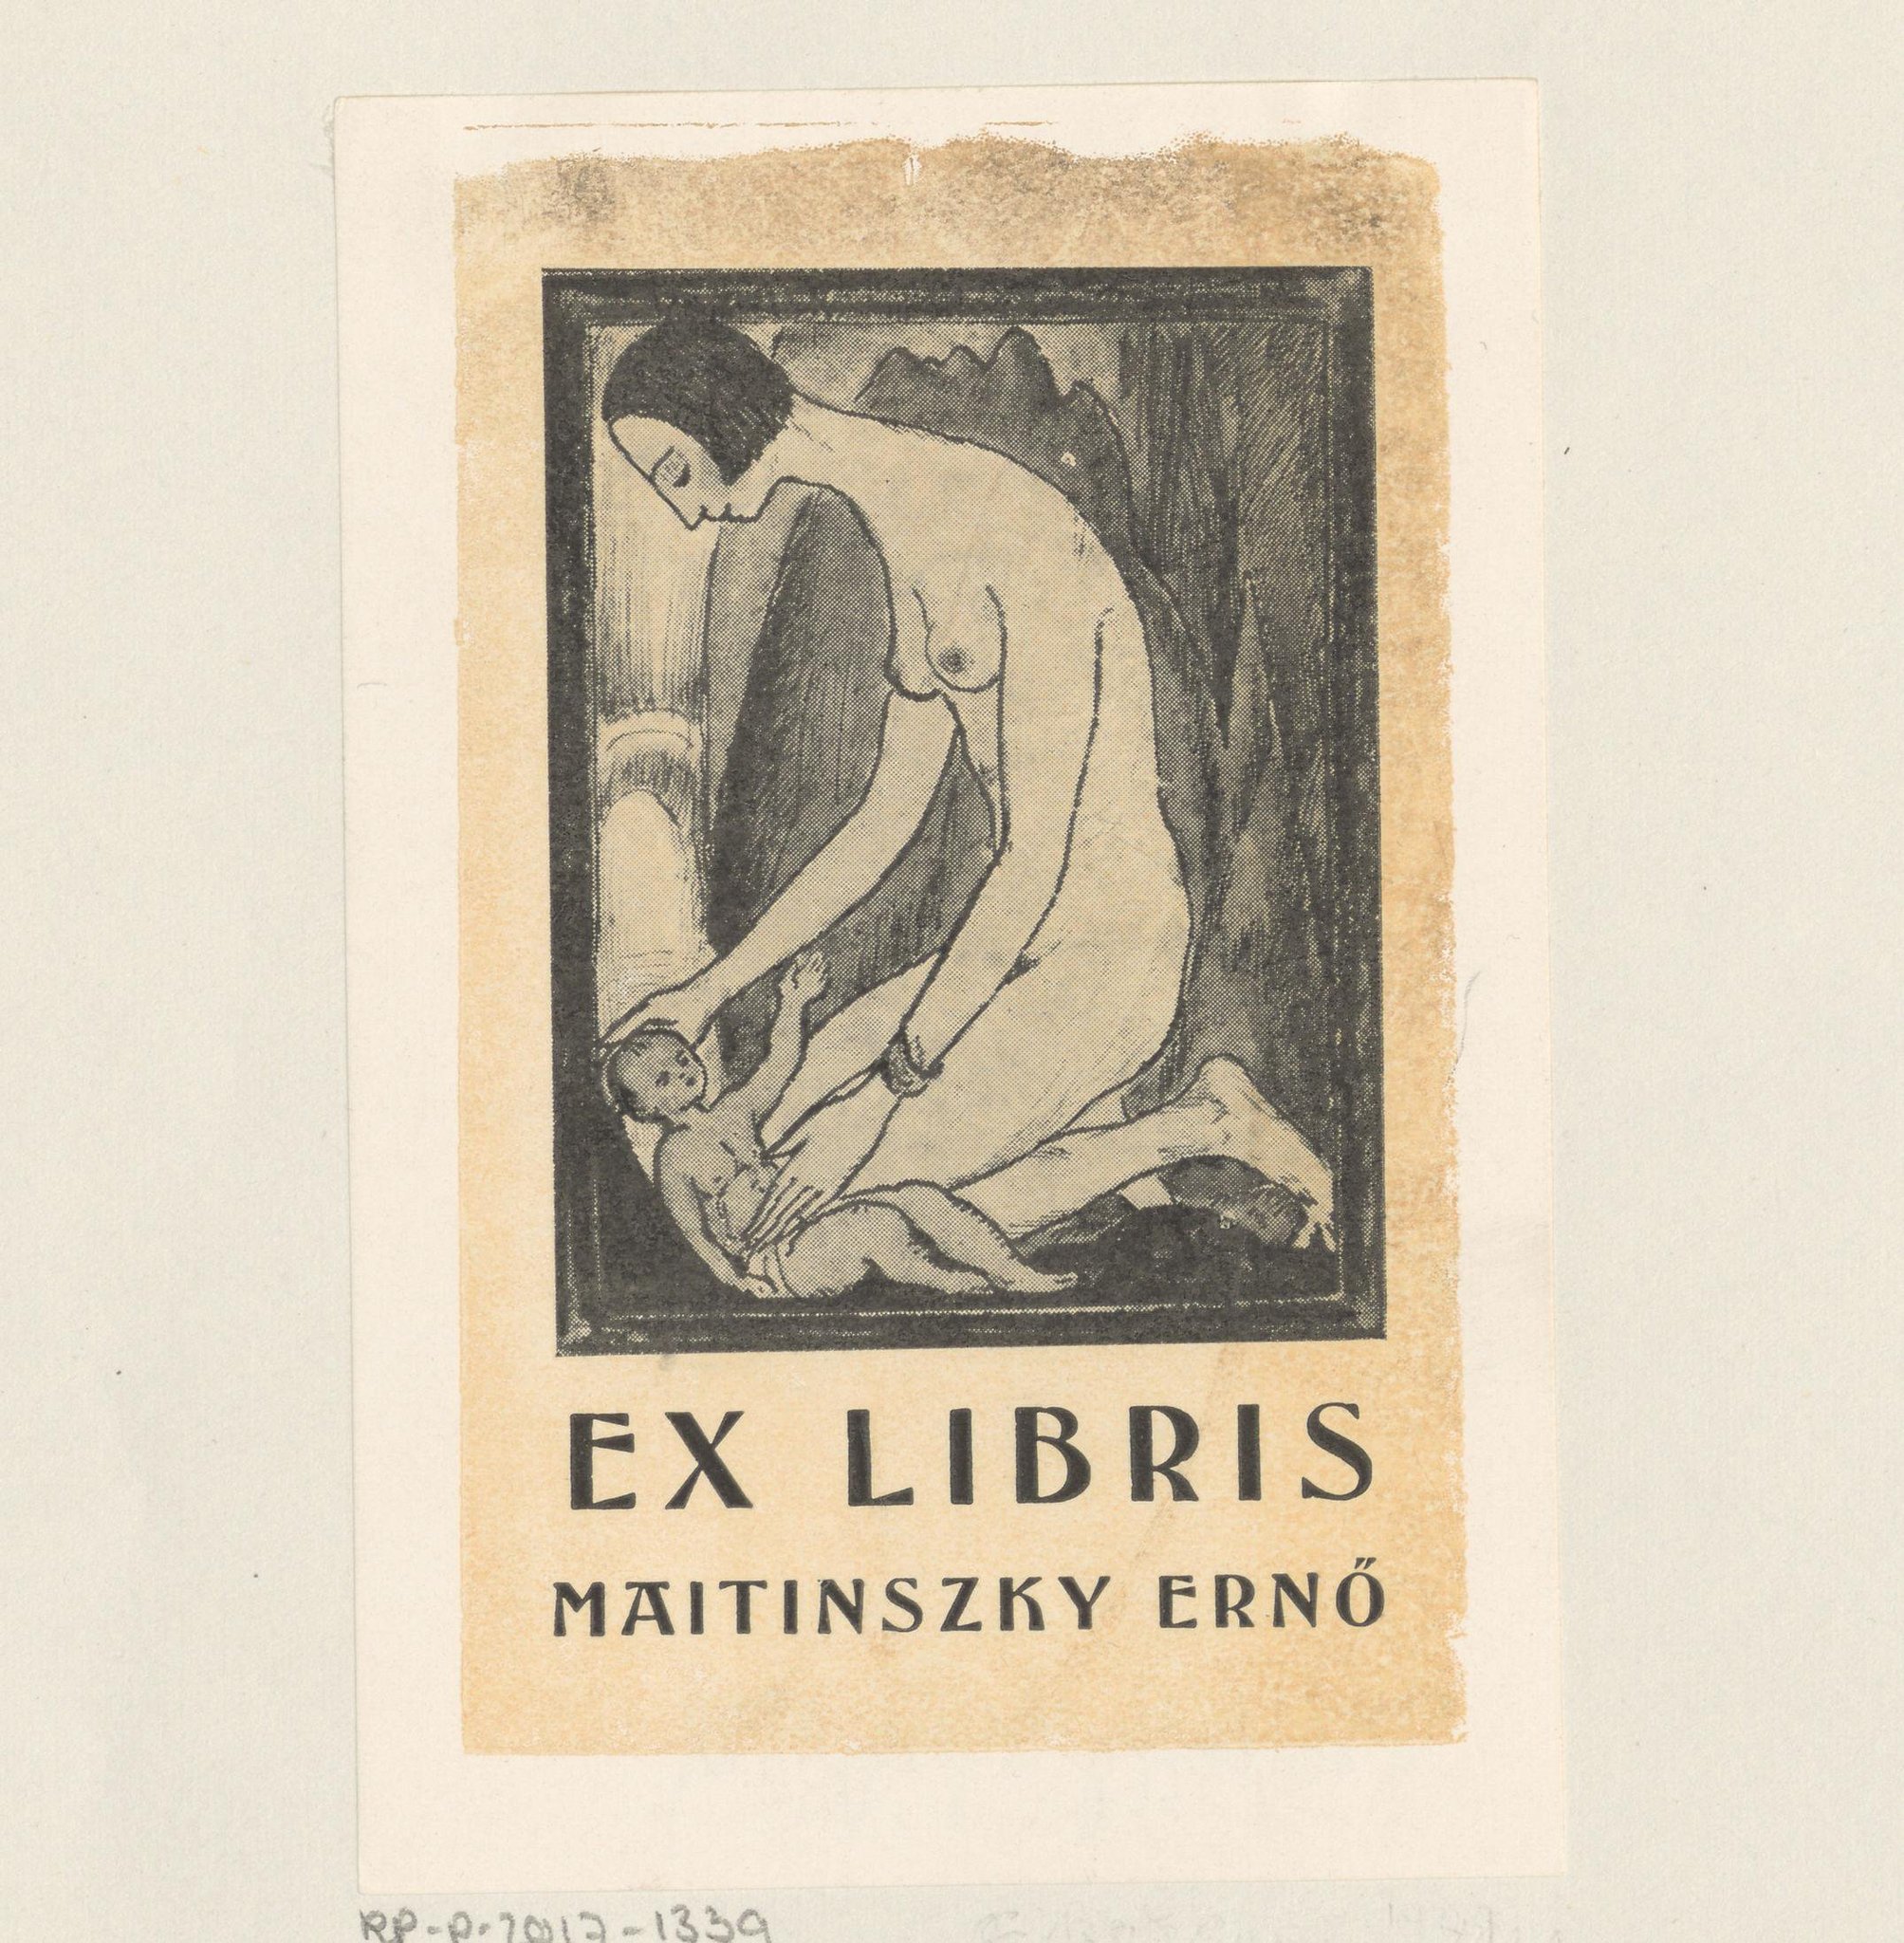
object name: bookplate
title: Ex libris van Ernö Maitinszky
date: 1929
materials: paper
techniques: planographic printing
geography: hungary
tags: woman (showing herself) undressed, quasi-nude, mother and baby or young child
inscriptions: signature and date: ‘Bètzeffy (?) Gyórgy 1929’